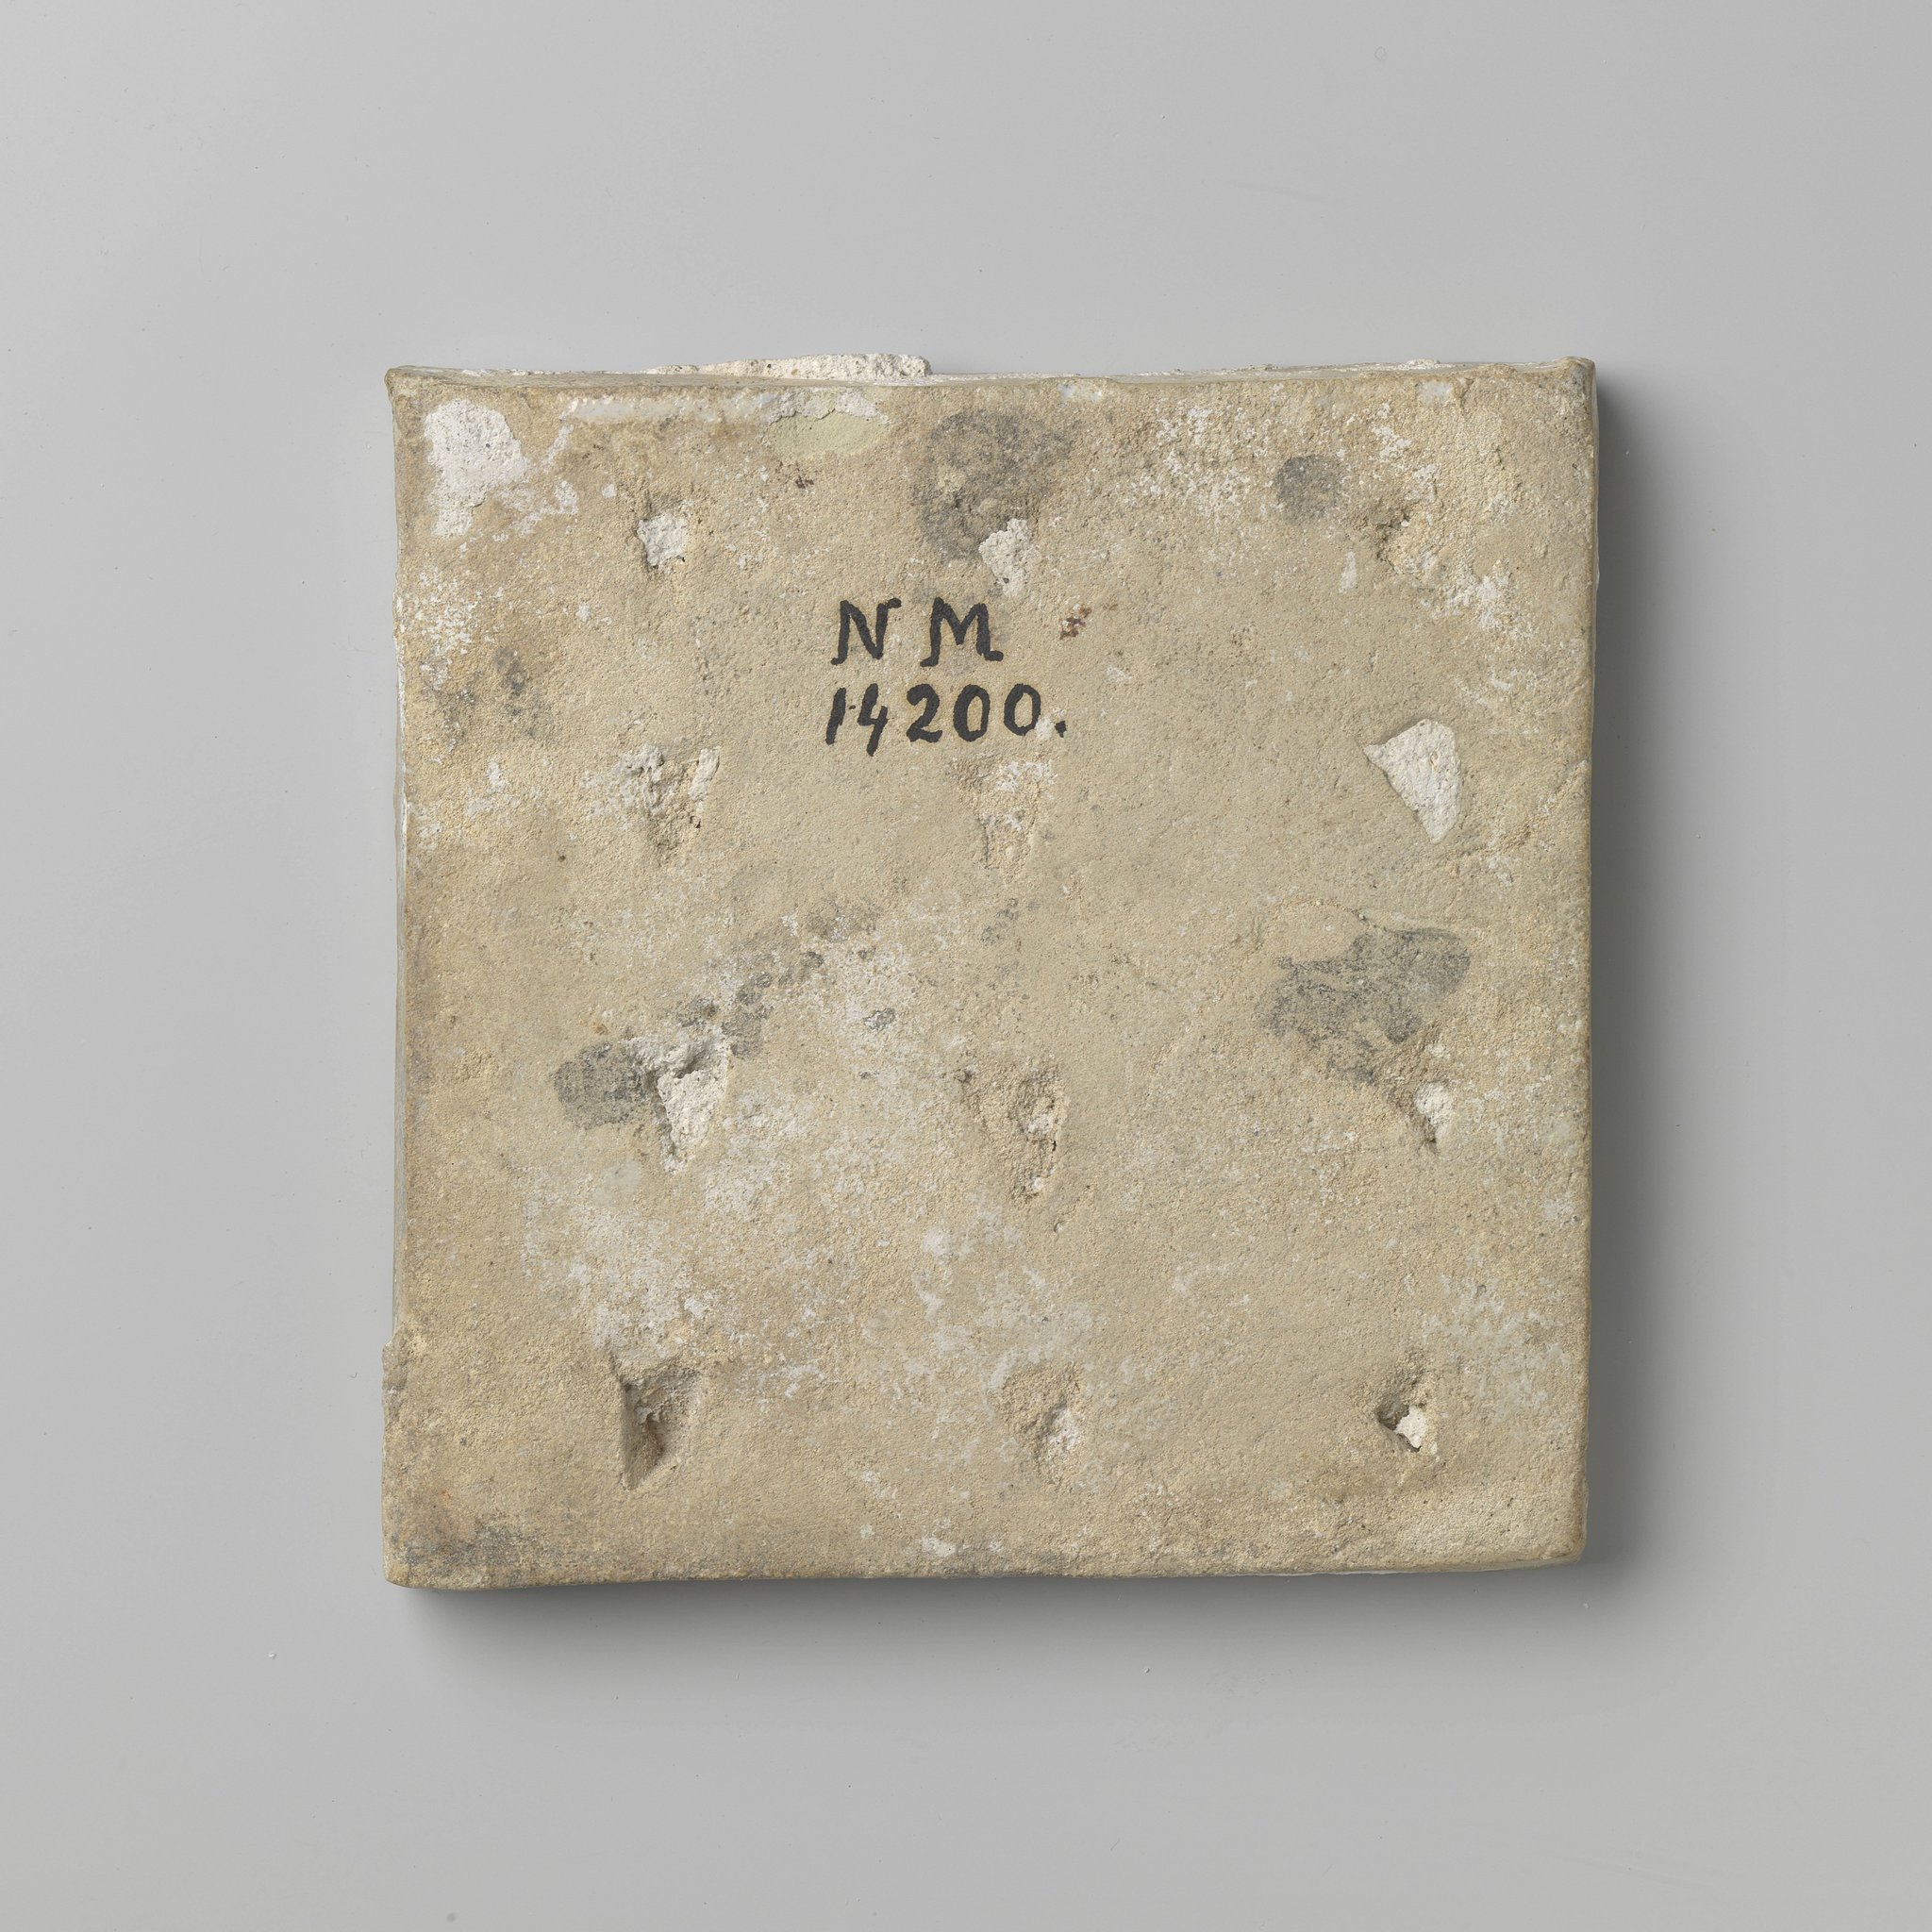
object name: tile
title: Tegel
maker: Anonymous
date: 1720-1730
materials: earthenware, glaze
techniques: maiolica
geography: marseille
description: Tegel met een paars geschilderd landschap binnen een cirkel met in de hoeken, krulornament.